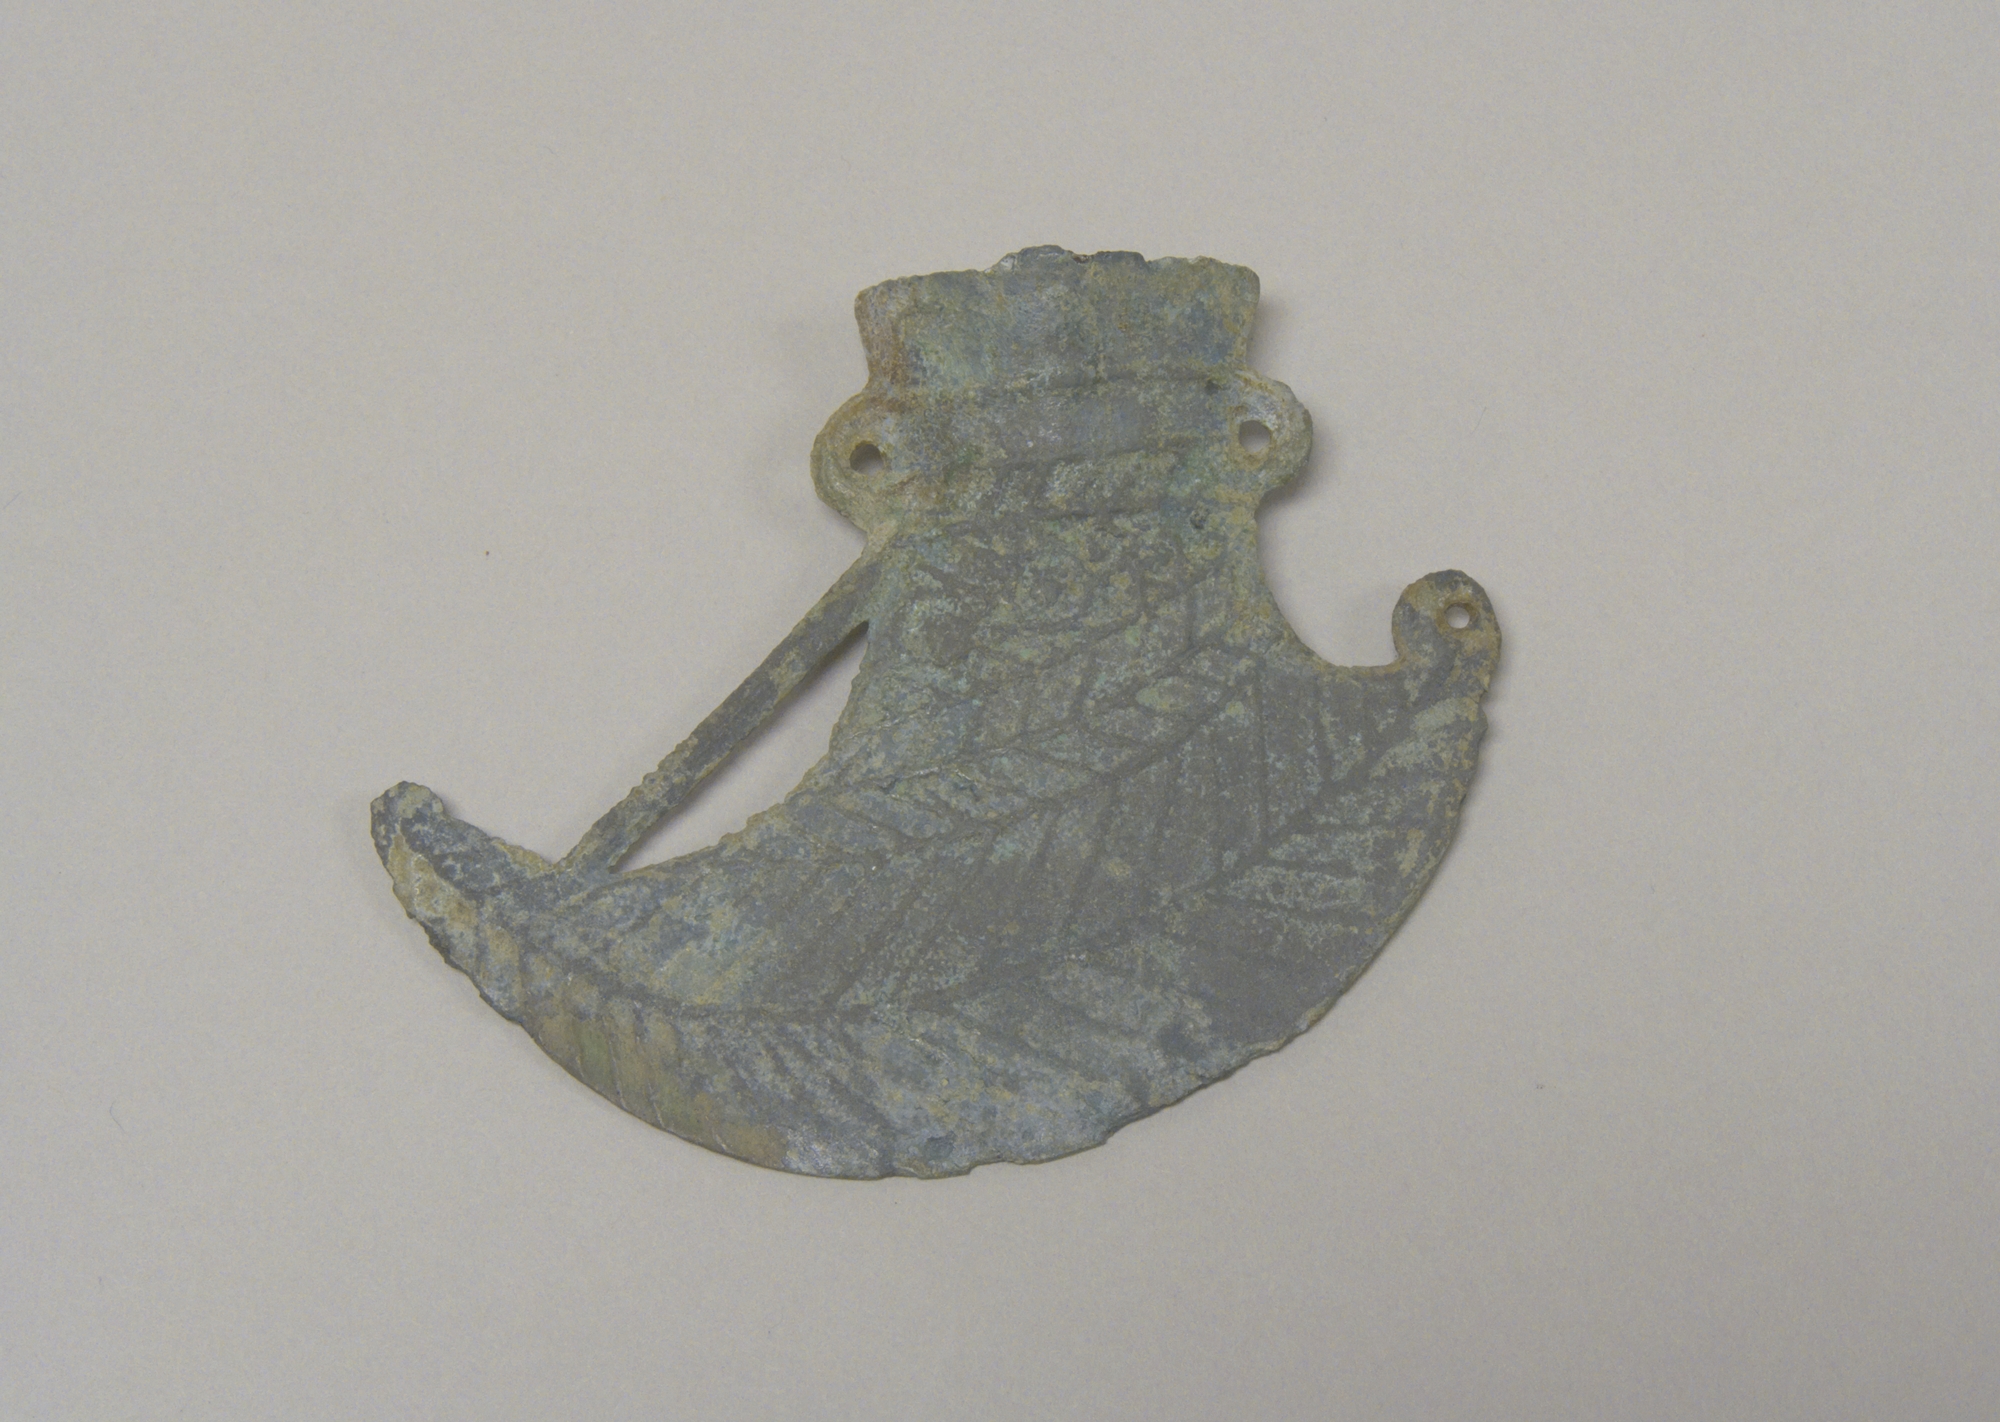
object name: hafted ax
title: Asymmetric Pediform Hafted Ax with Striated Decoration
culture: vietnamese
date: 500 BCE-300 CE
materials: bronze